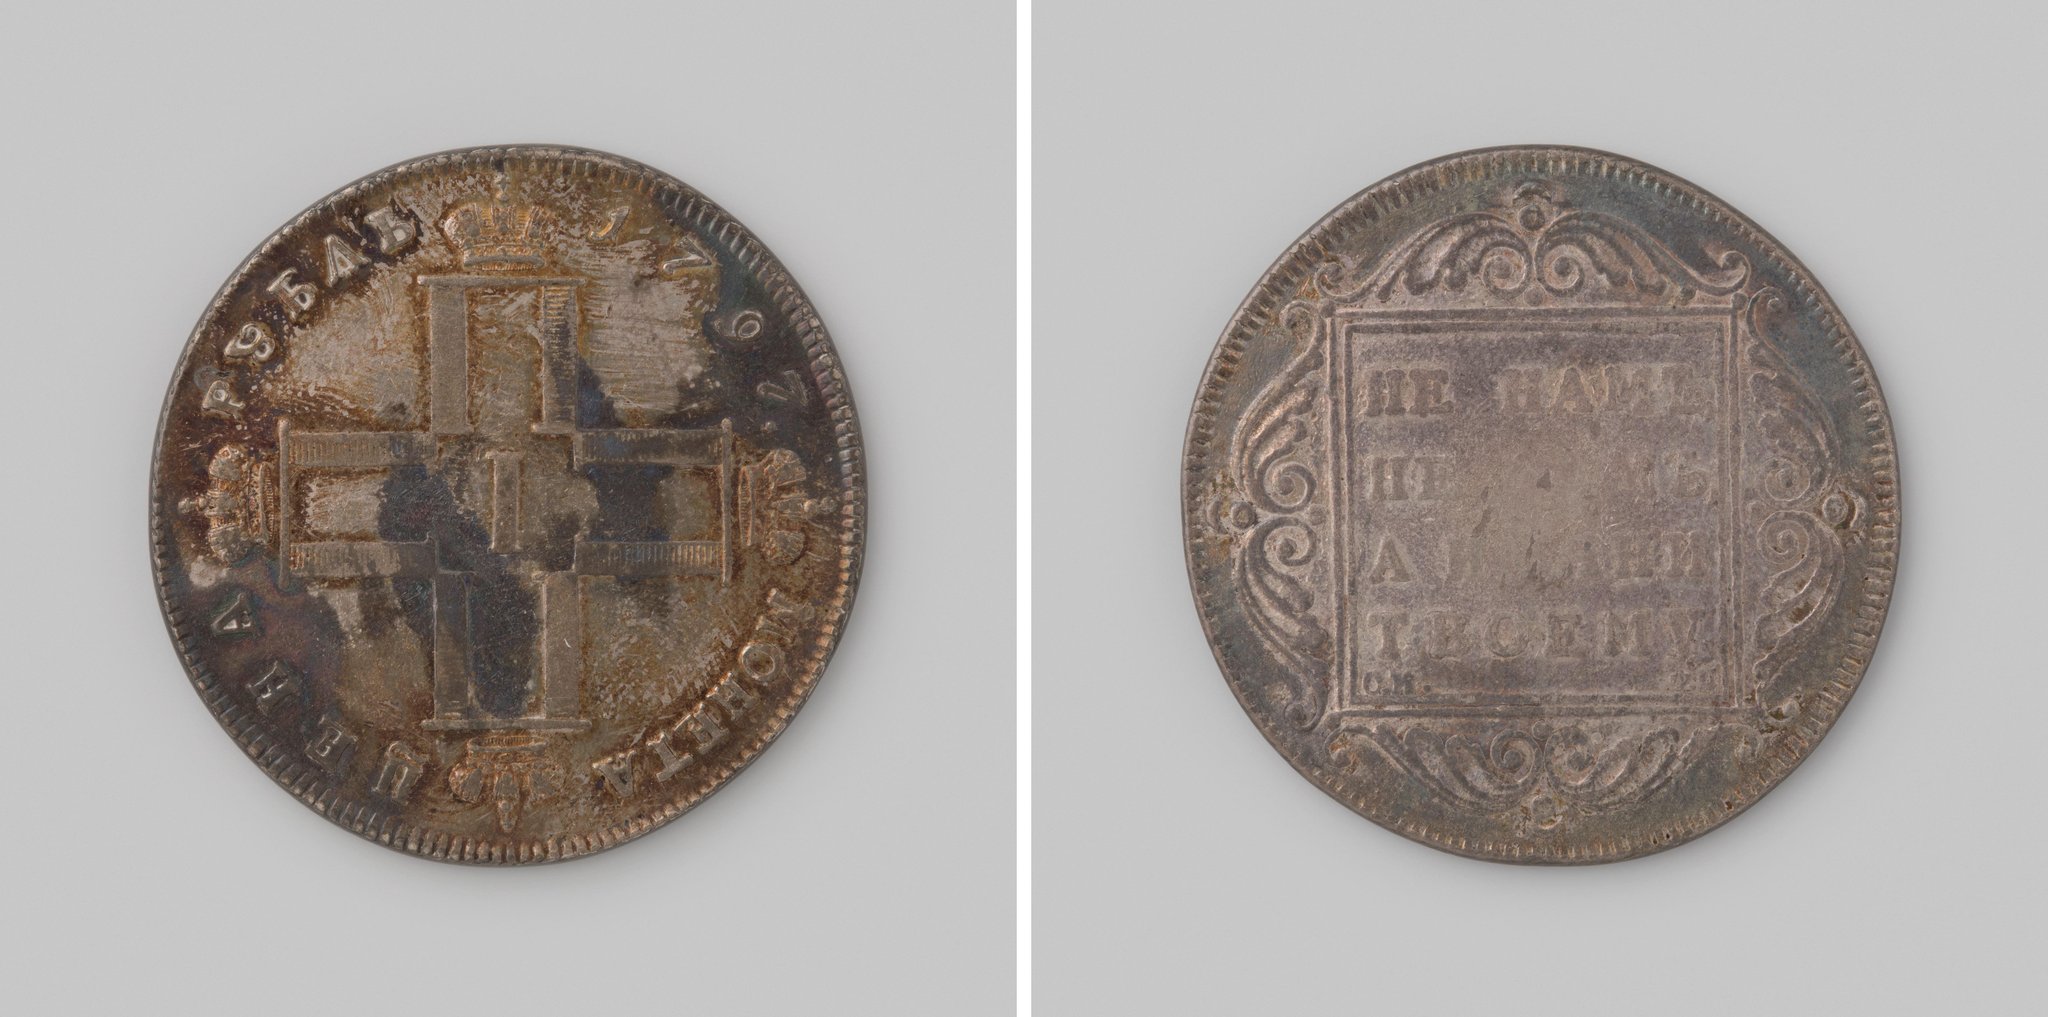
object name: coin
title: Rusland, tsaar Paul I, roebel, 1797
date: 1797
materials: silver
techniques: striking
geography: sint-petersburg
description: Zilveren munt. Voorzijde: monogram van de czaar in de vorm van een kruis met op de uiteinden een kroon en in het centrum de aanduiding: I. Waarde-aanduiding in het omschrift en jaartal in het omschrift. Keerzijde: Keerzijde: binnen een versiering een dubbellijnig vierkant, waarin vierregelige tekst. Links onder de letters S en M in Cyrilisch schrift. Gladde rand.